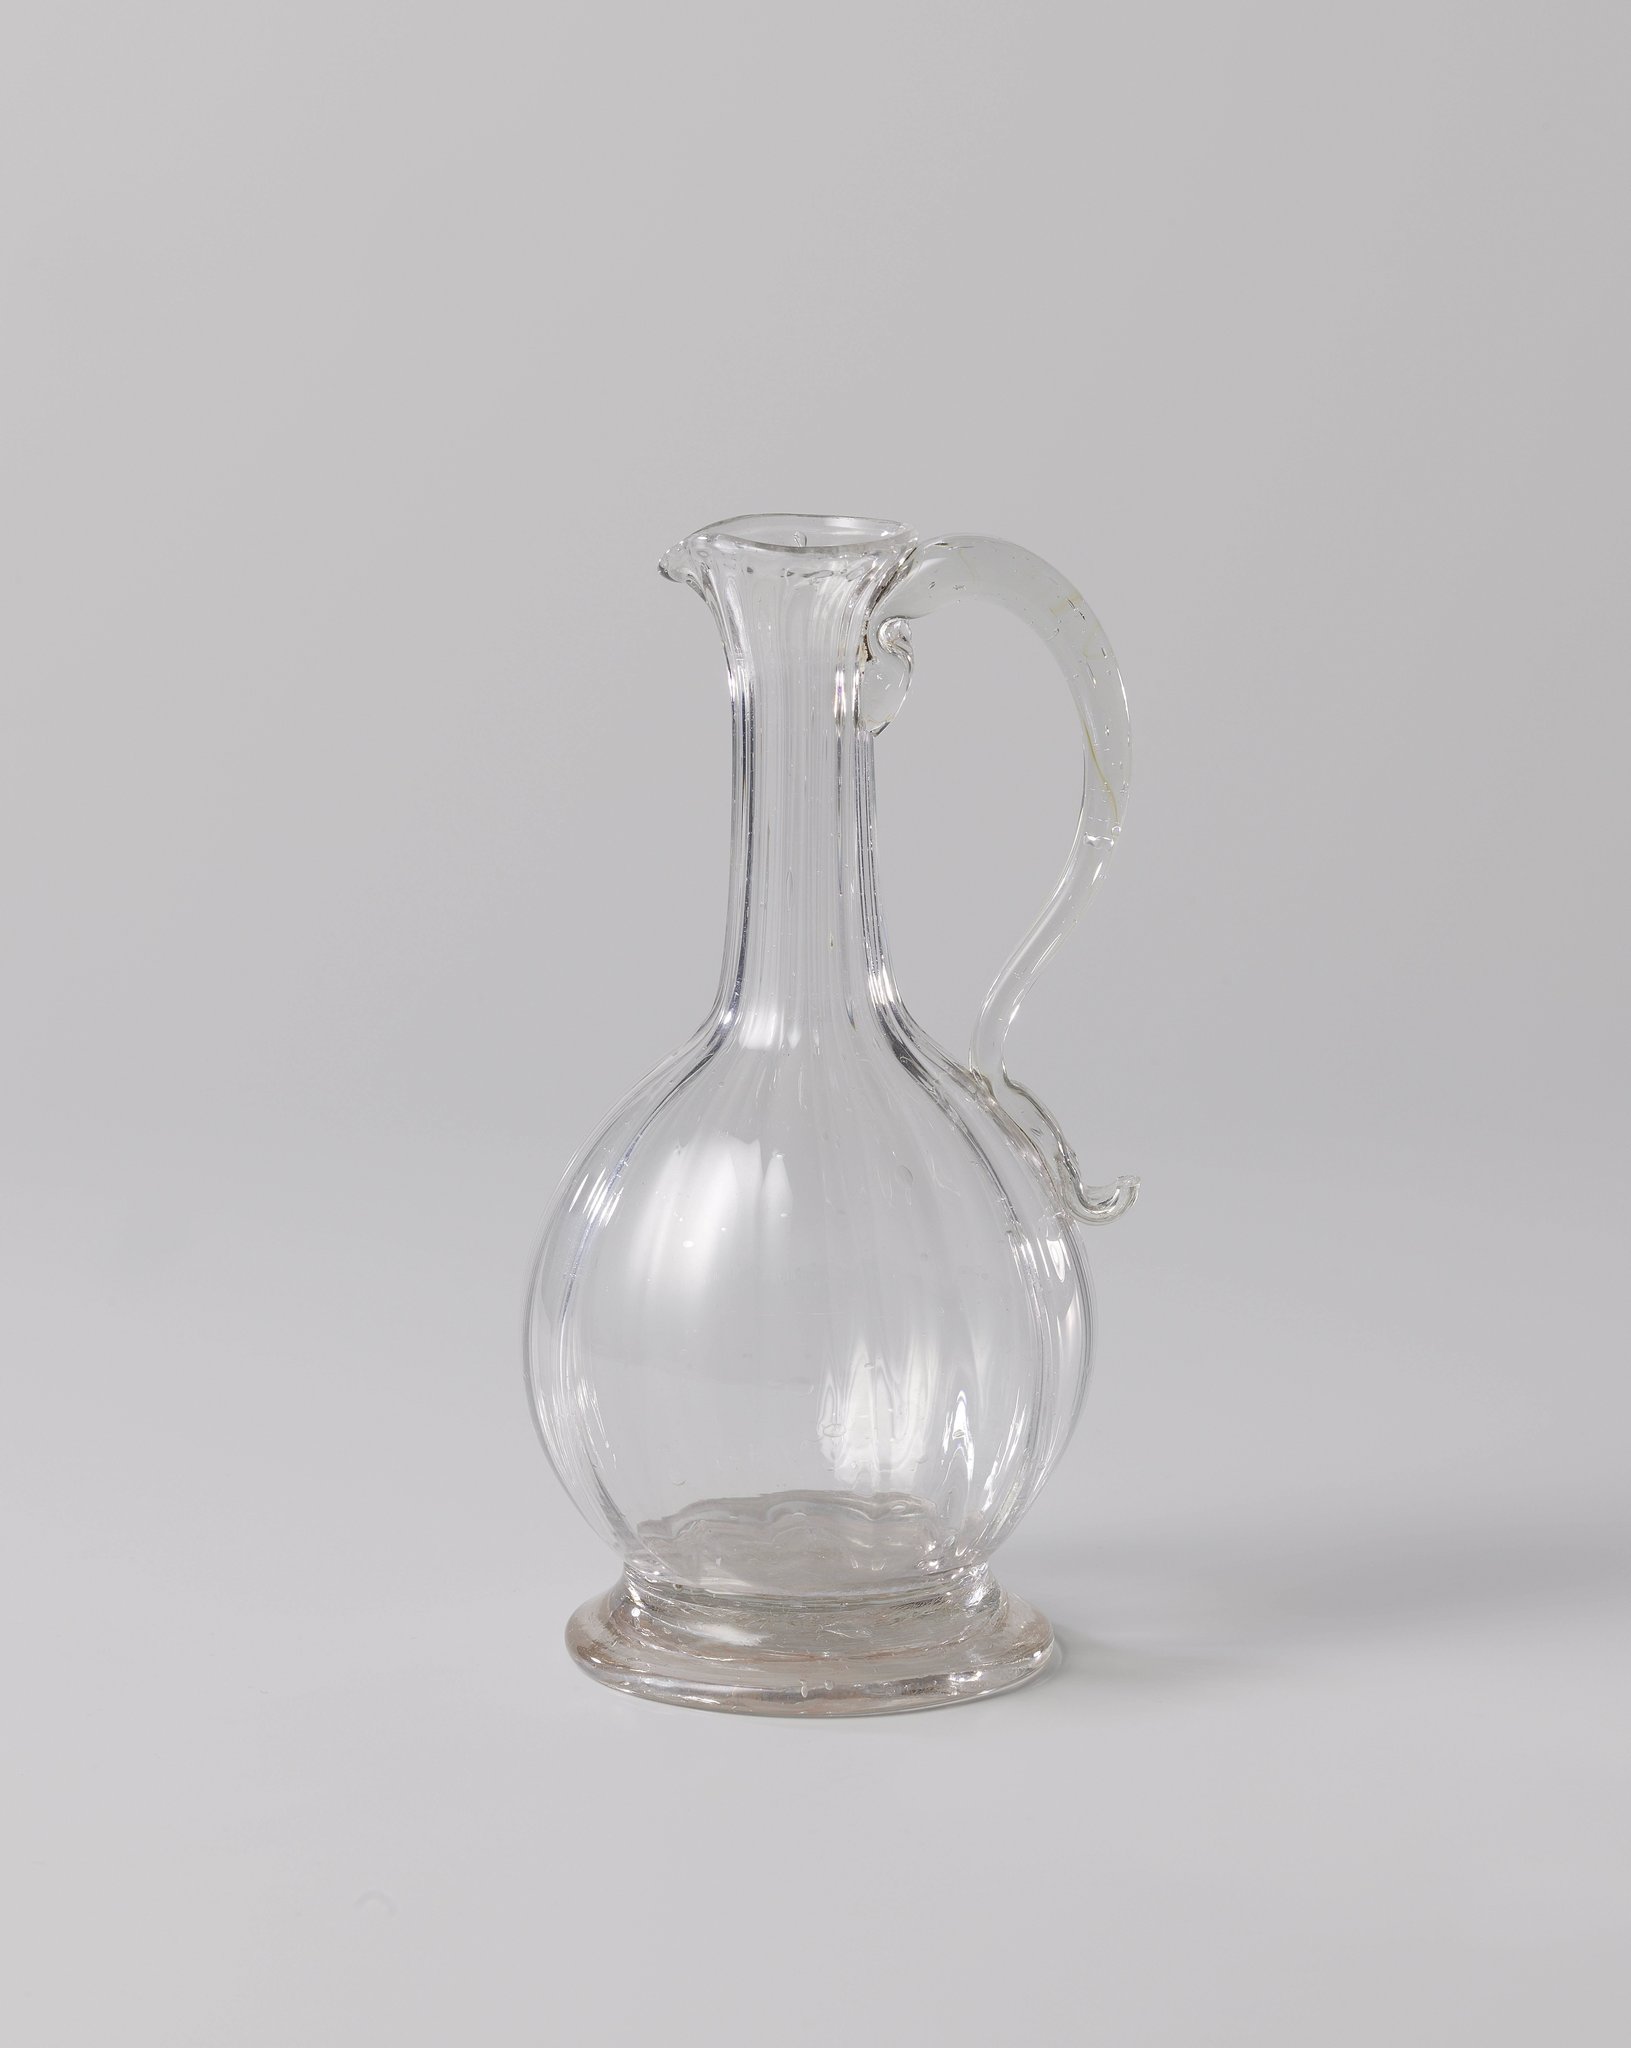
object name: ewer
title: Kan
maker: Anonymous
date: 1750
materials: glass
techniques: glassblowing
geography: venice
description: Kan op concave voet. Bolvormig lichaam overgaande in een slanke hals met een uitgebogen tuit, optisch geblazen met verticale ribben. C-vormig oor